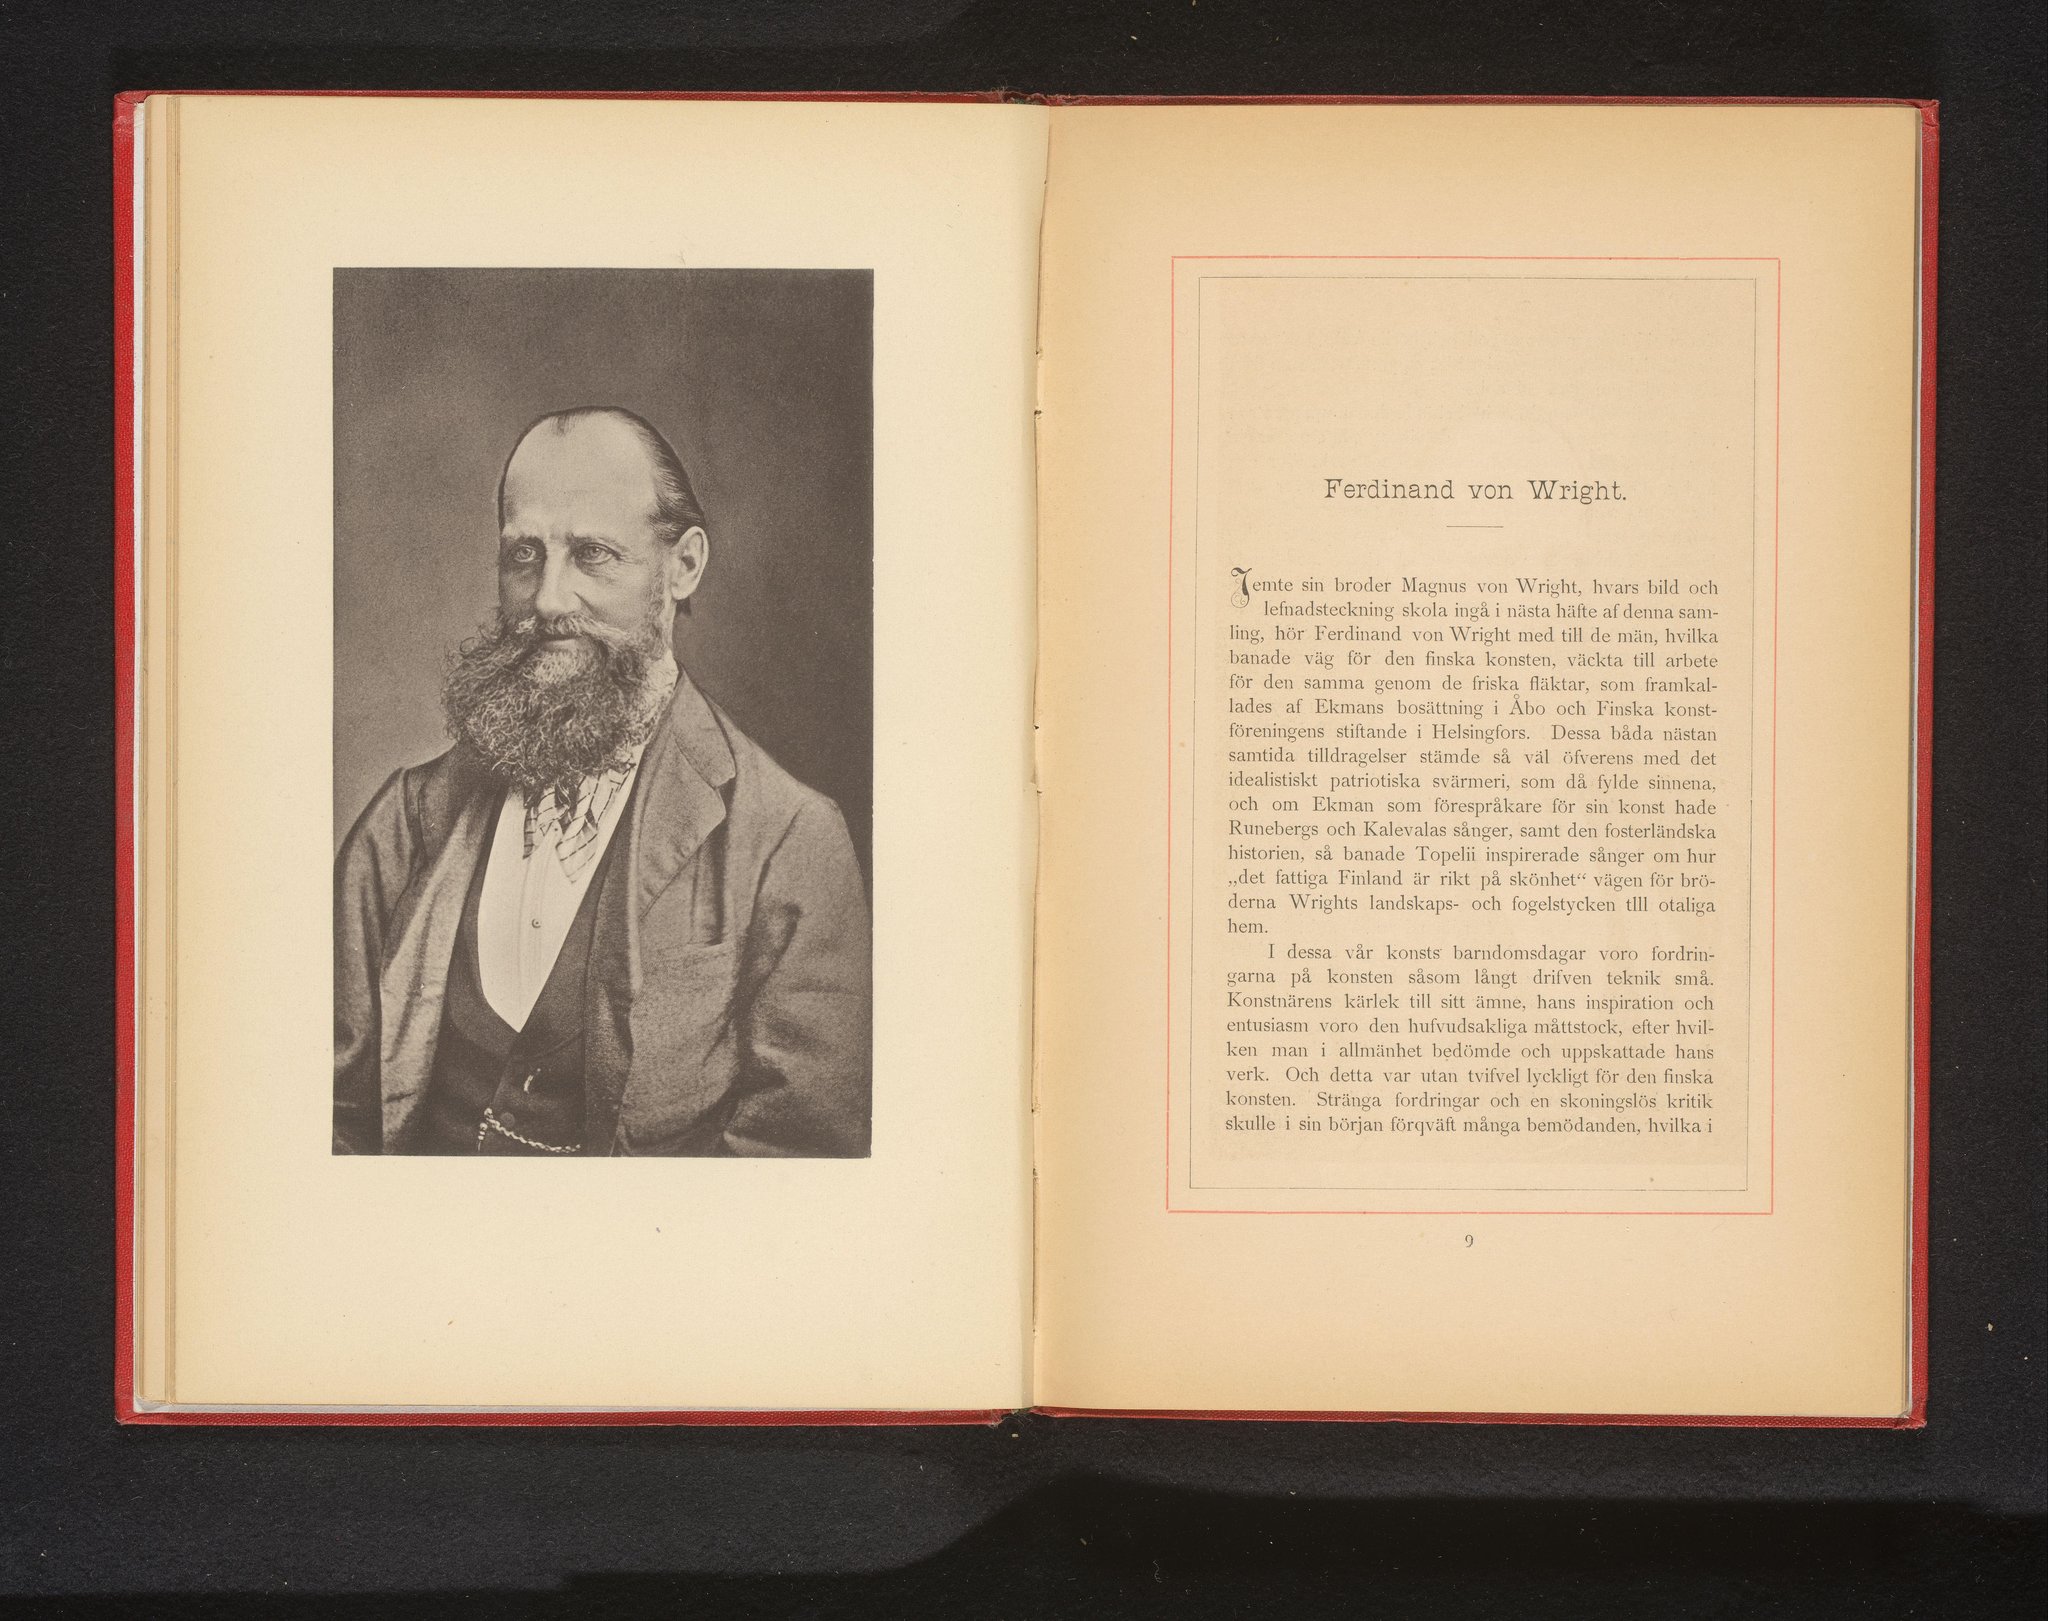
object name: page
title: Portret van Ferdinand von Wright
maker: Anonymous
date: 1873-1883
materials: paper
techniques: photograph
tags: painter, portrait, self-portrait of painter